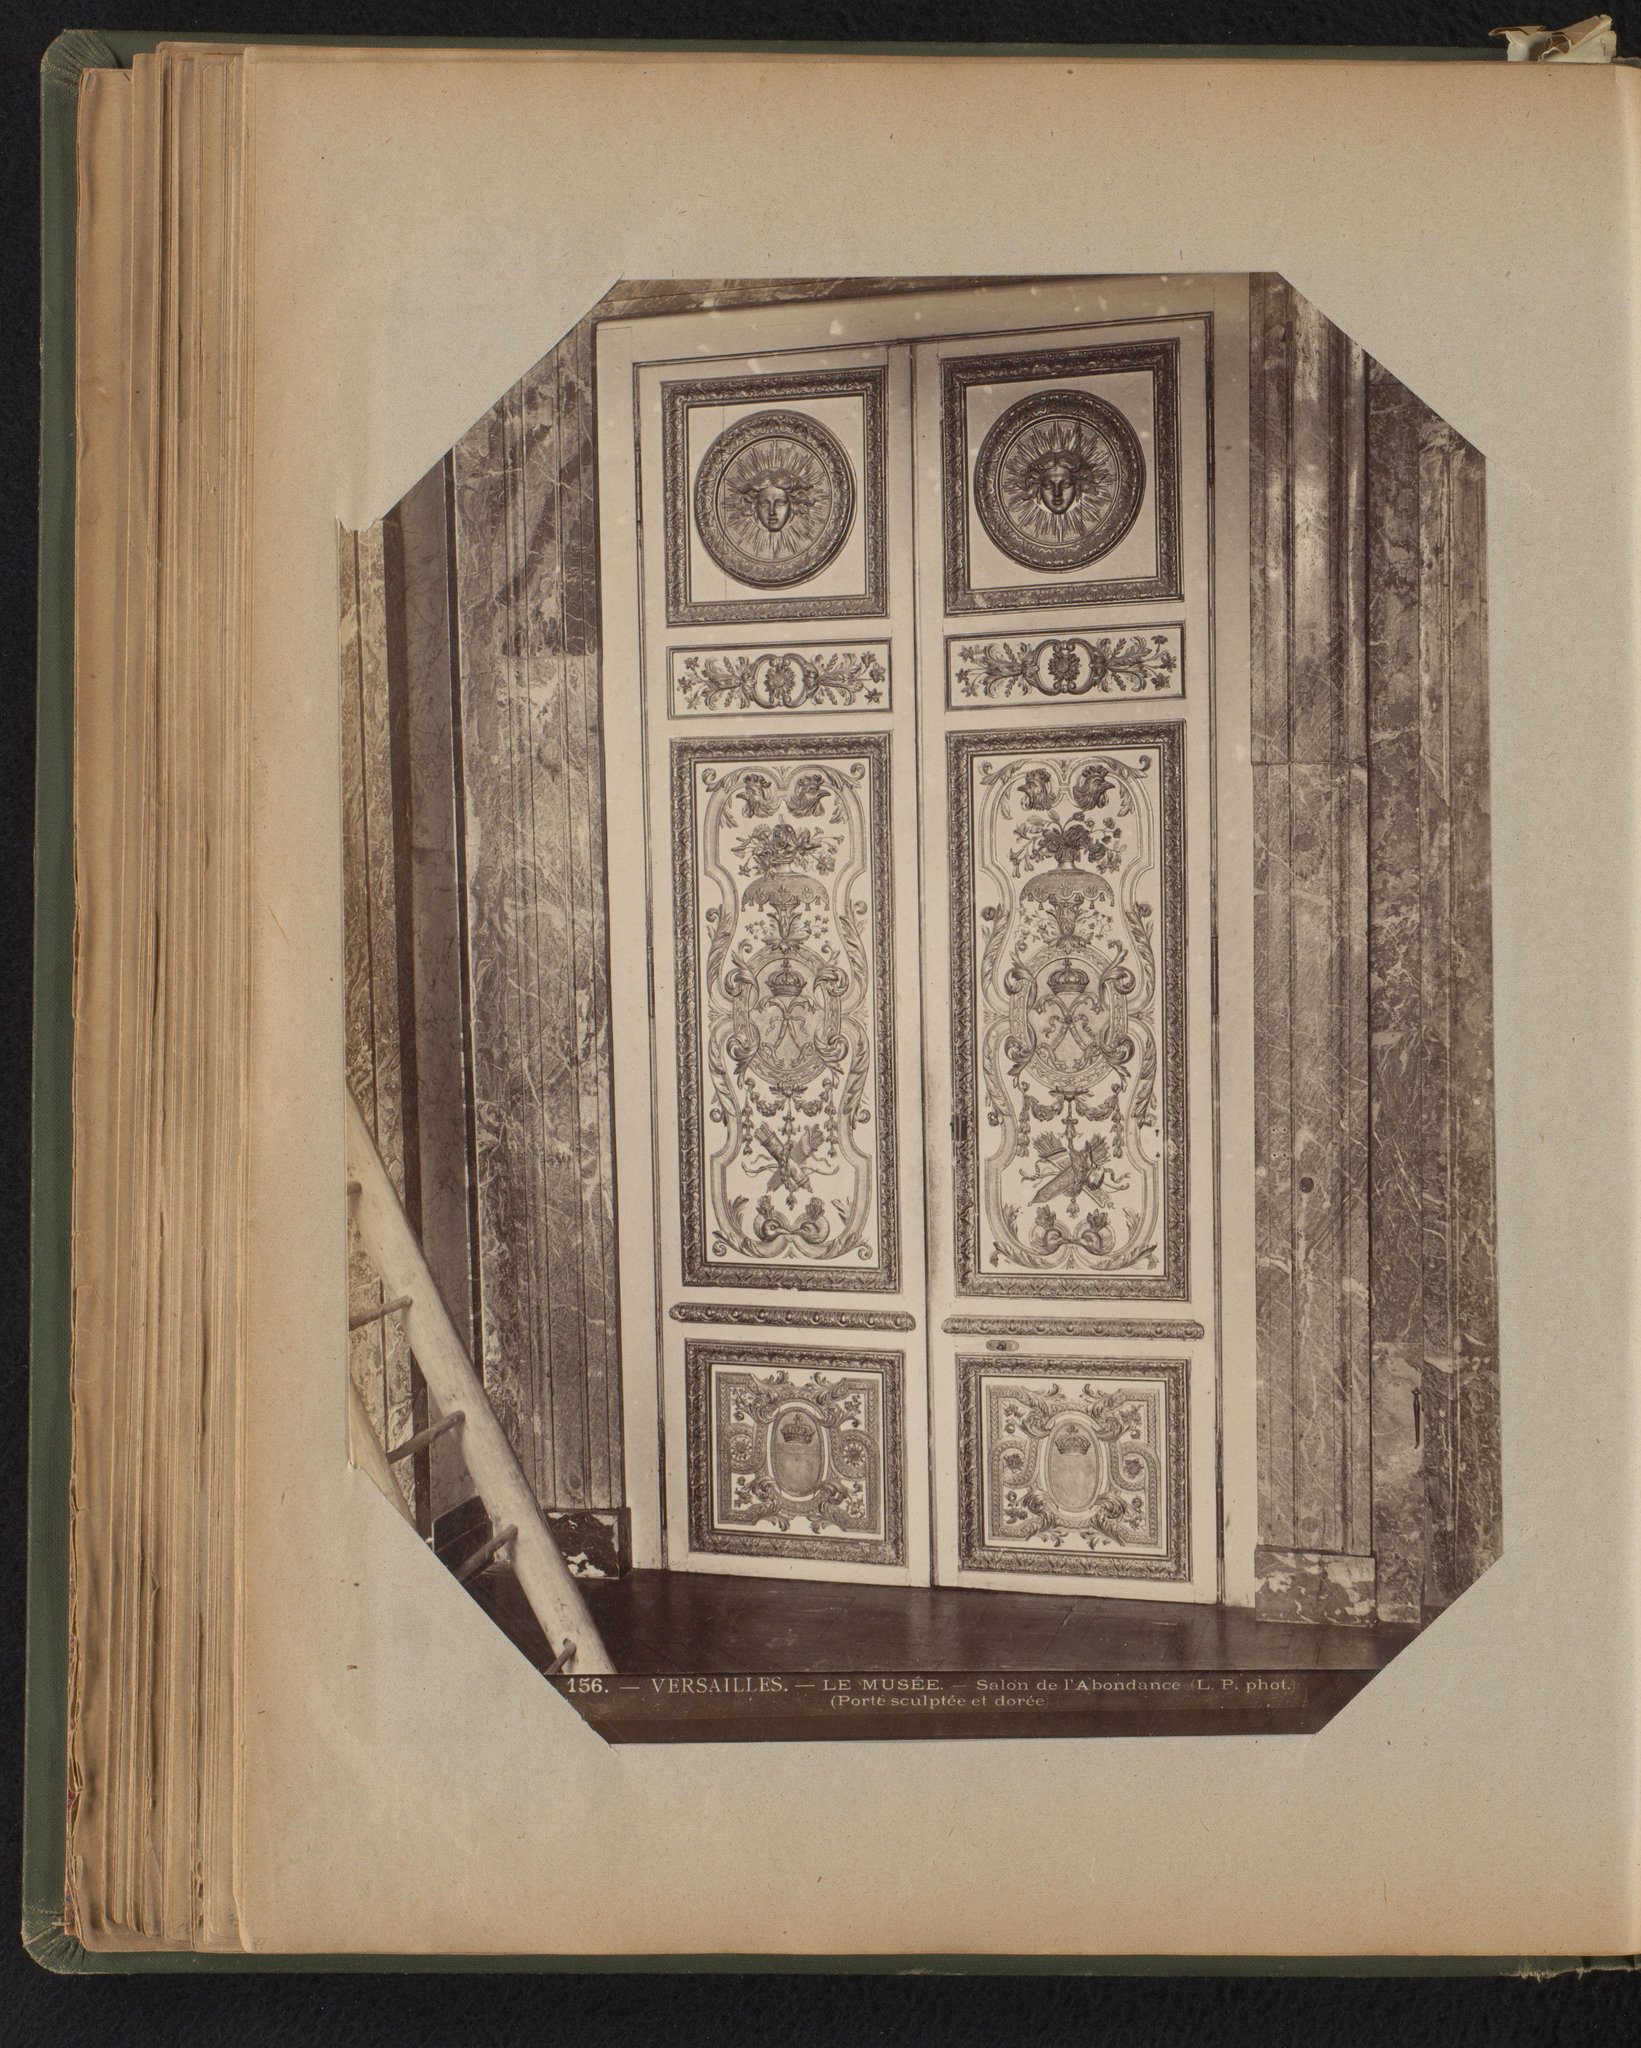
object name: photograph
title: Twee met vergulde ornamenten gedecoreerde deuren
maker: Anonymous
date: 1860-1900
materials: paper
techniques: albumen print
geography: france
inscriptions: annotation: ‘156. Versailles - Le Musee - Salon de l'Abondance (L.P. Phot) (Porte Sculptee et doreé).’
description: Onderdeel van een serie met betrekking tot het interieur van het paleis van Versailles met kroonluchters, deuren, portalen en meubelstukken.